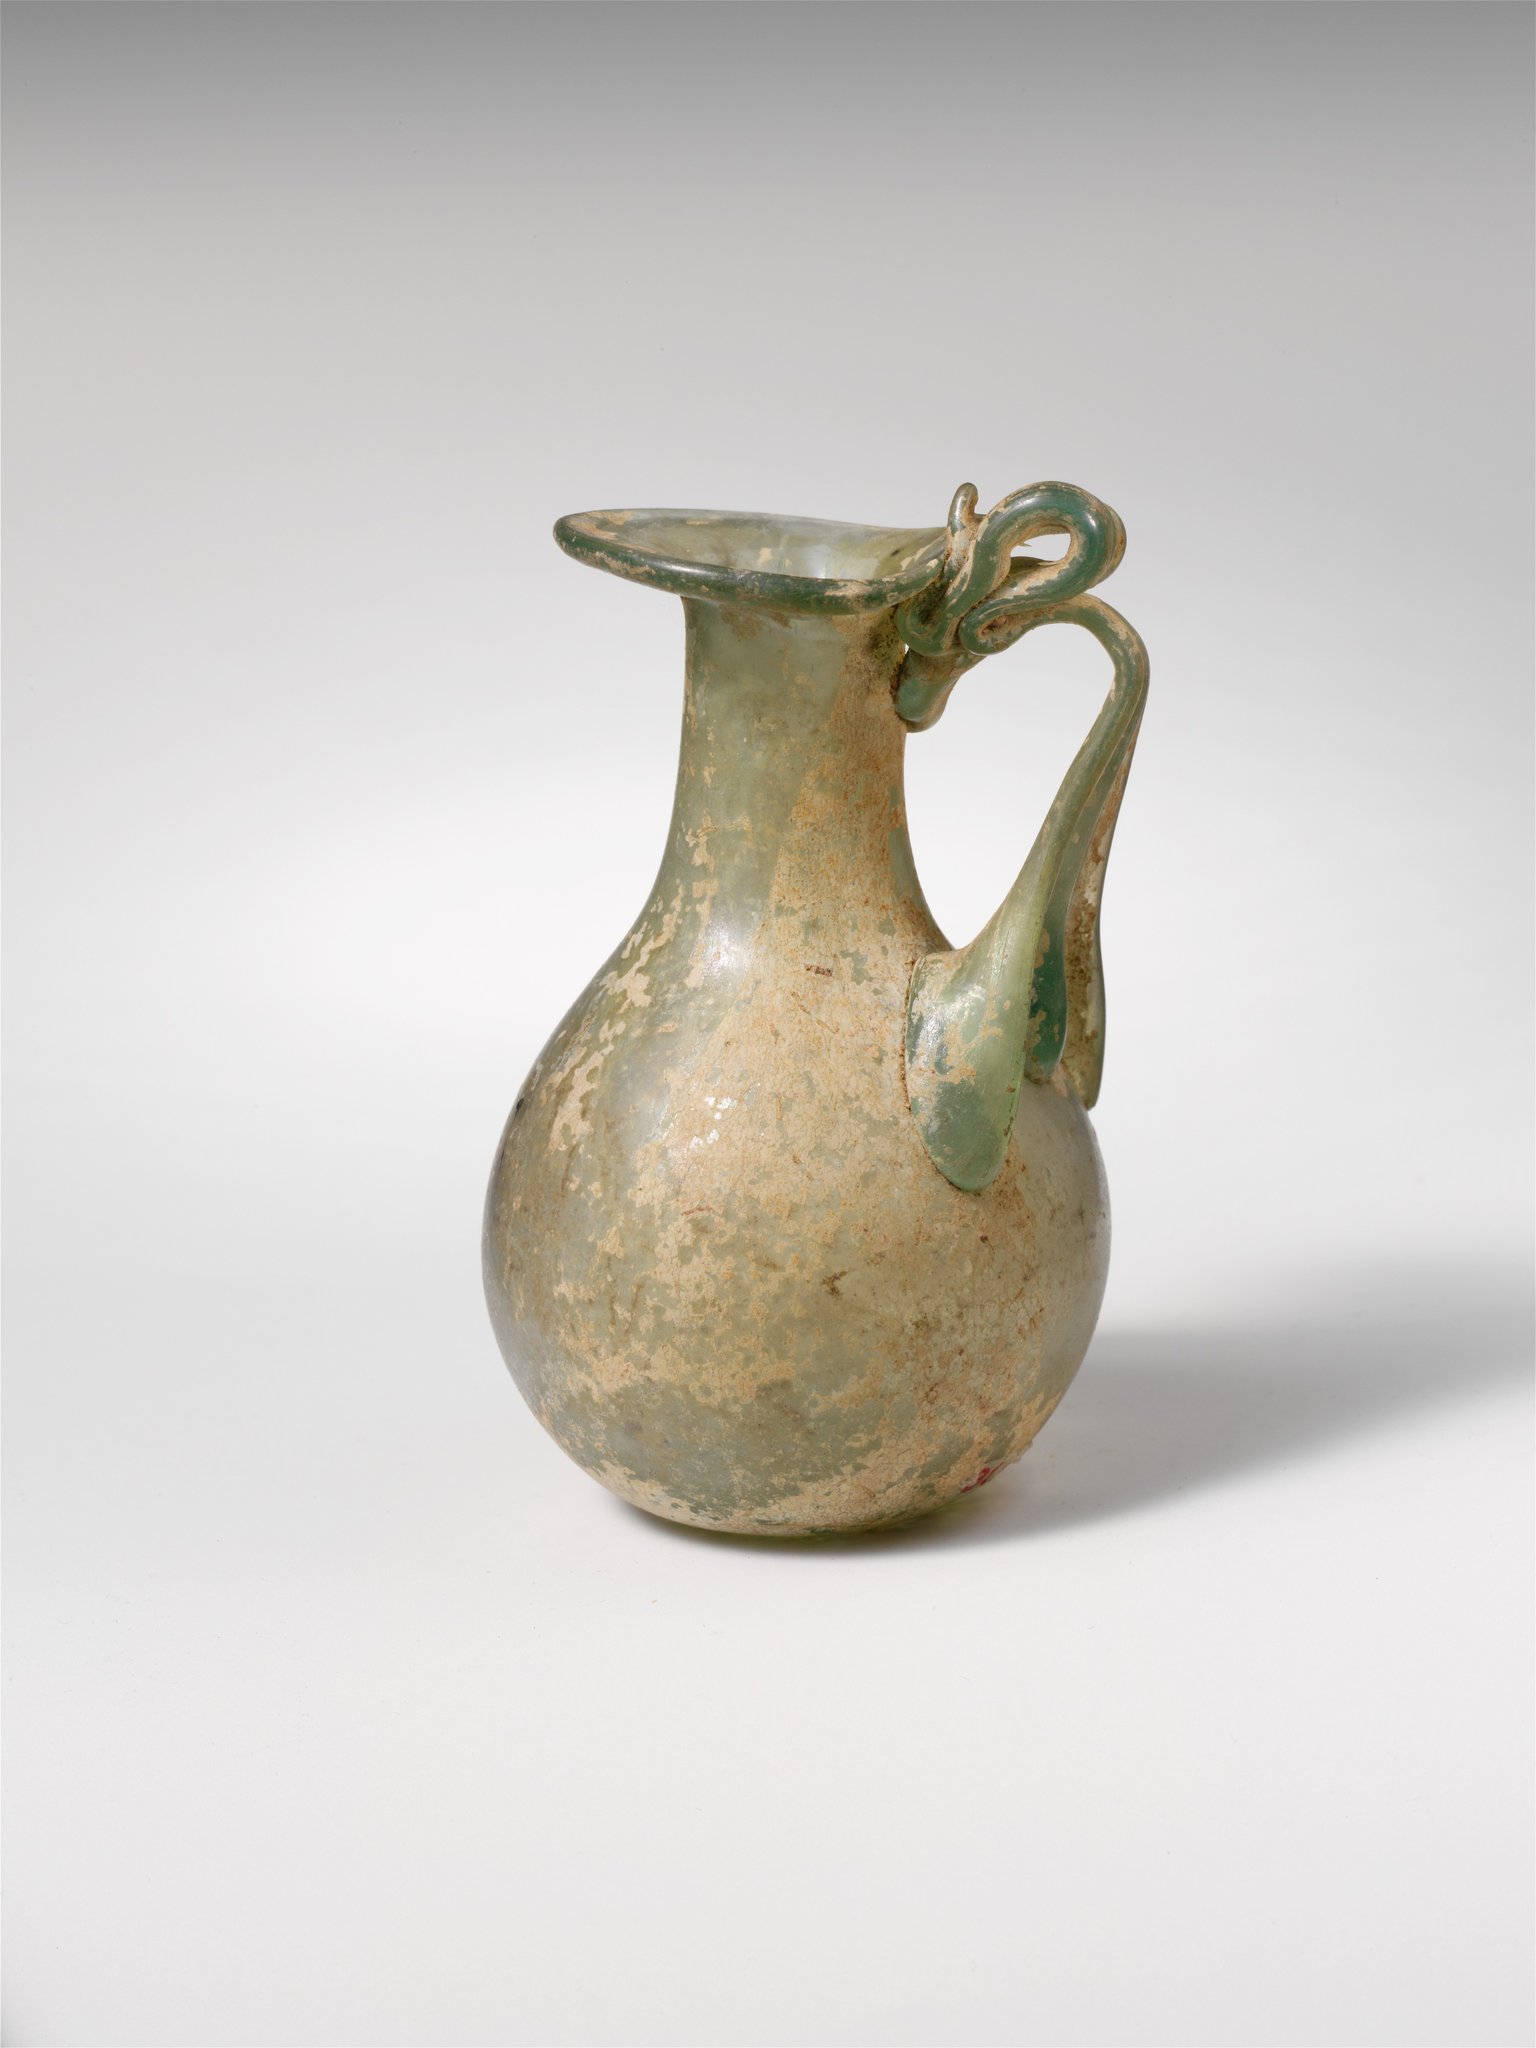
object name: jug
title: Glass jug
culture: roman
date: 1-300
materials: glass